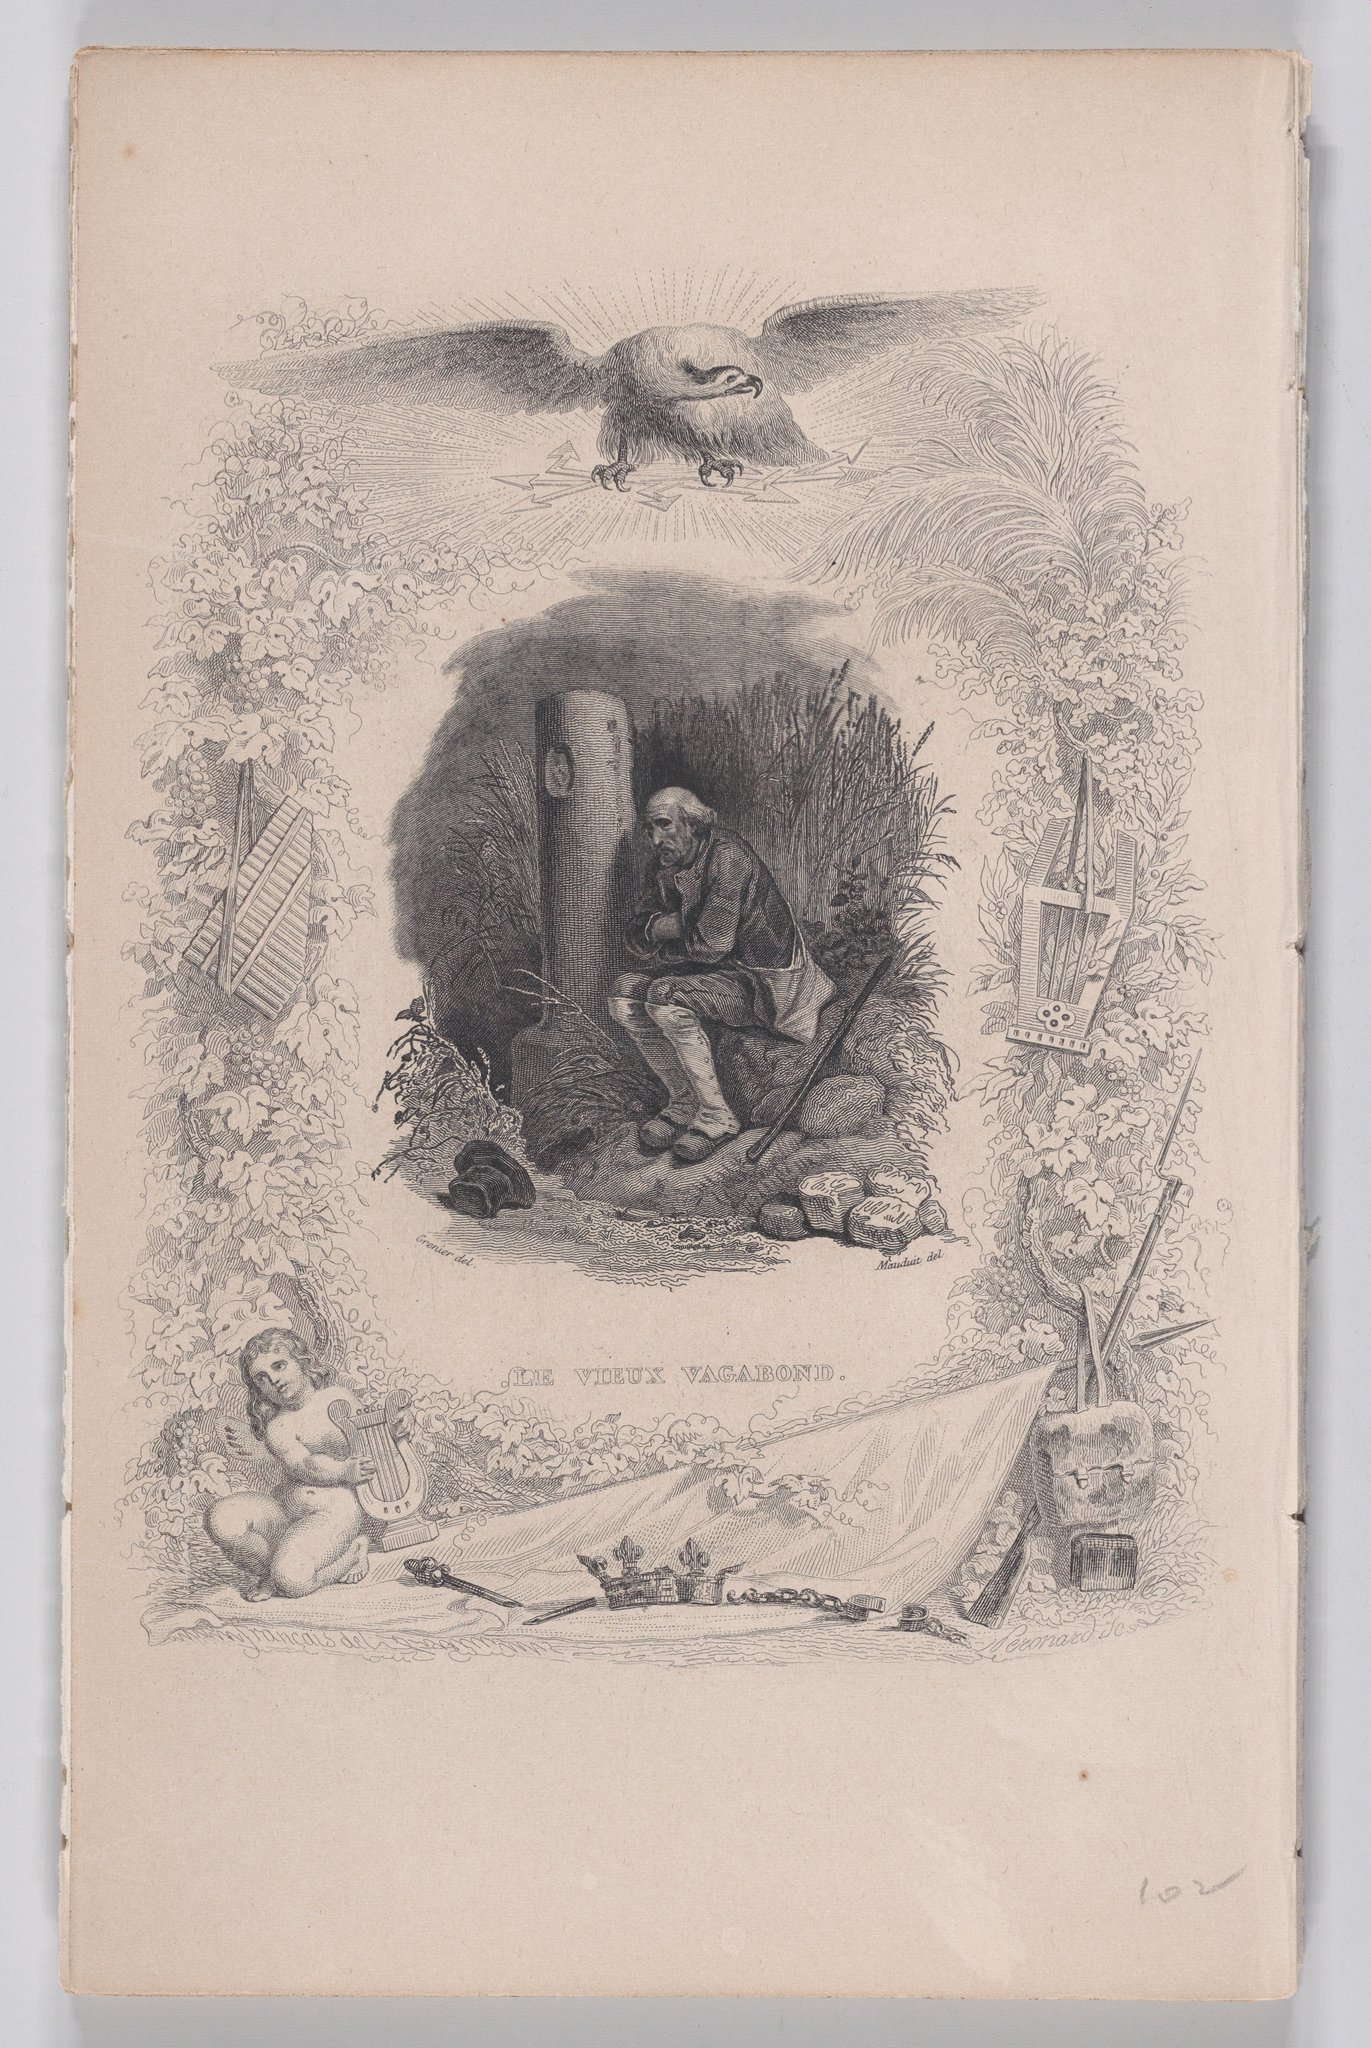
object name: print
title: The Old Vagabond, from "The Songs of Béranger"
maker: françois-louis français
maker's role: designer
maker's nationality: french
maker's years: 1814-1897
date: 1829